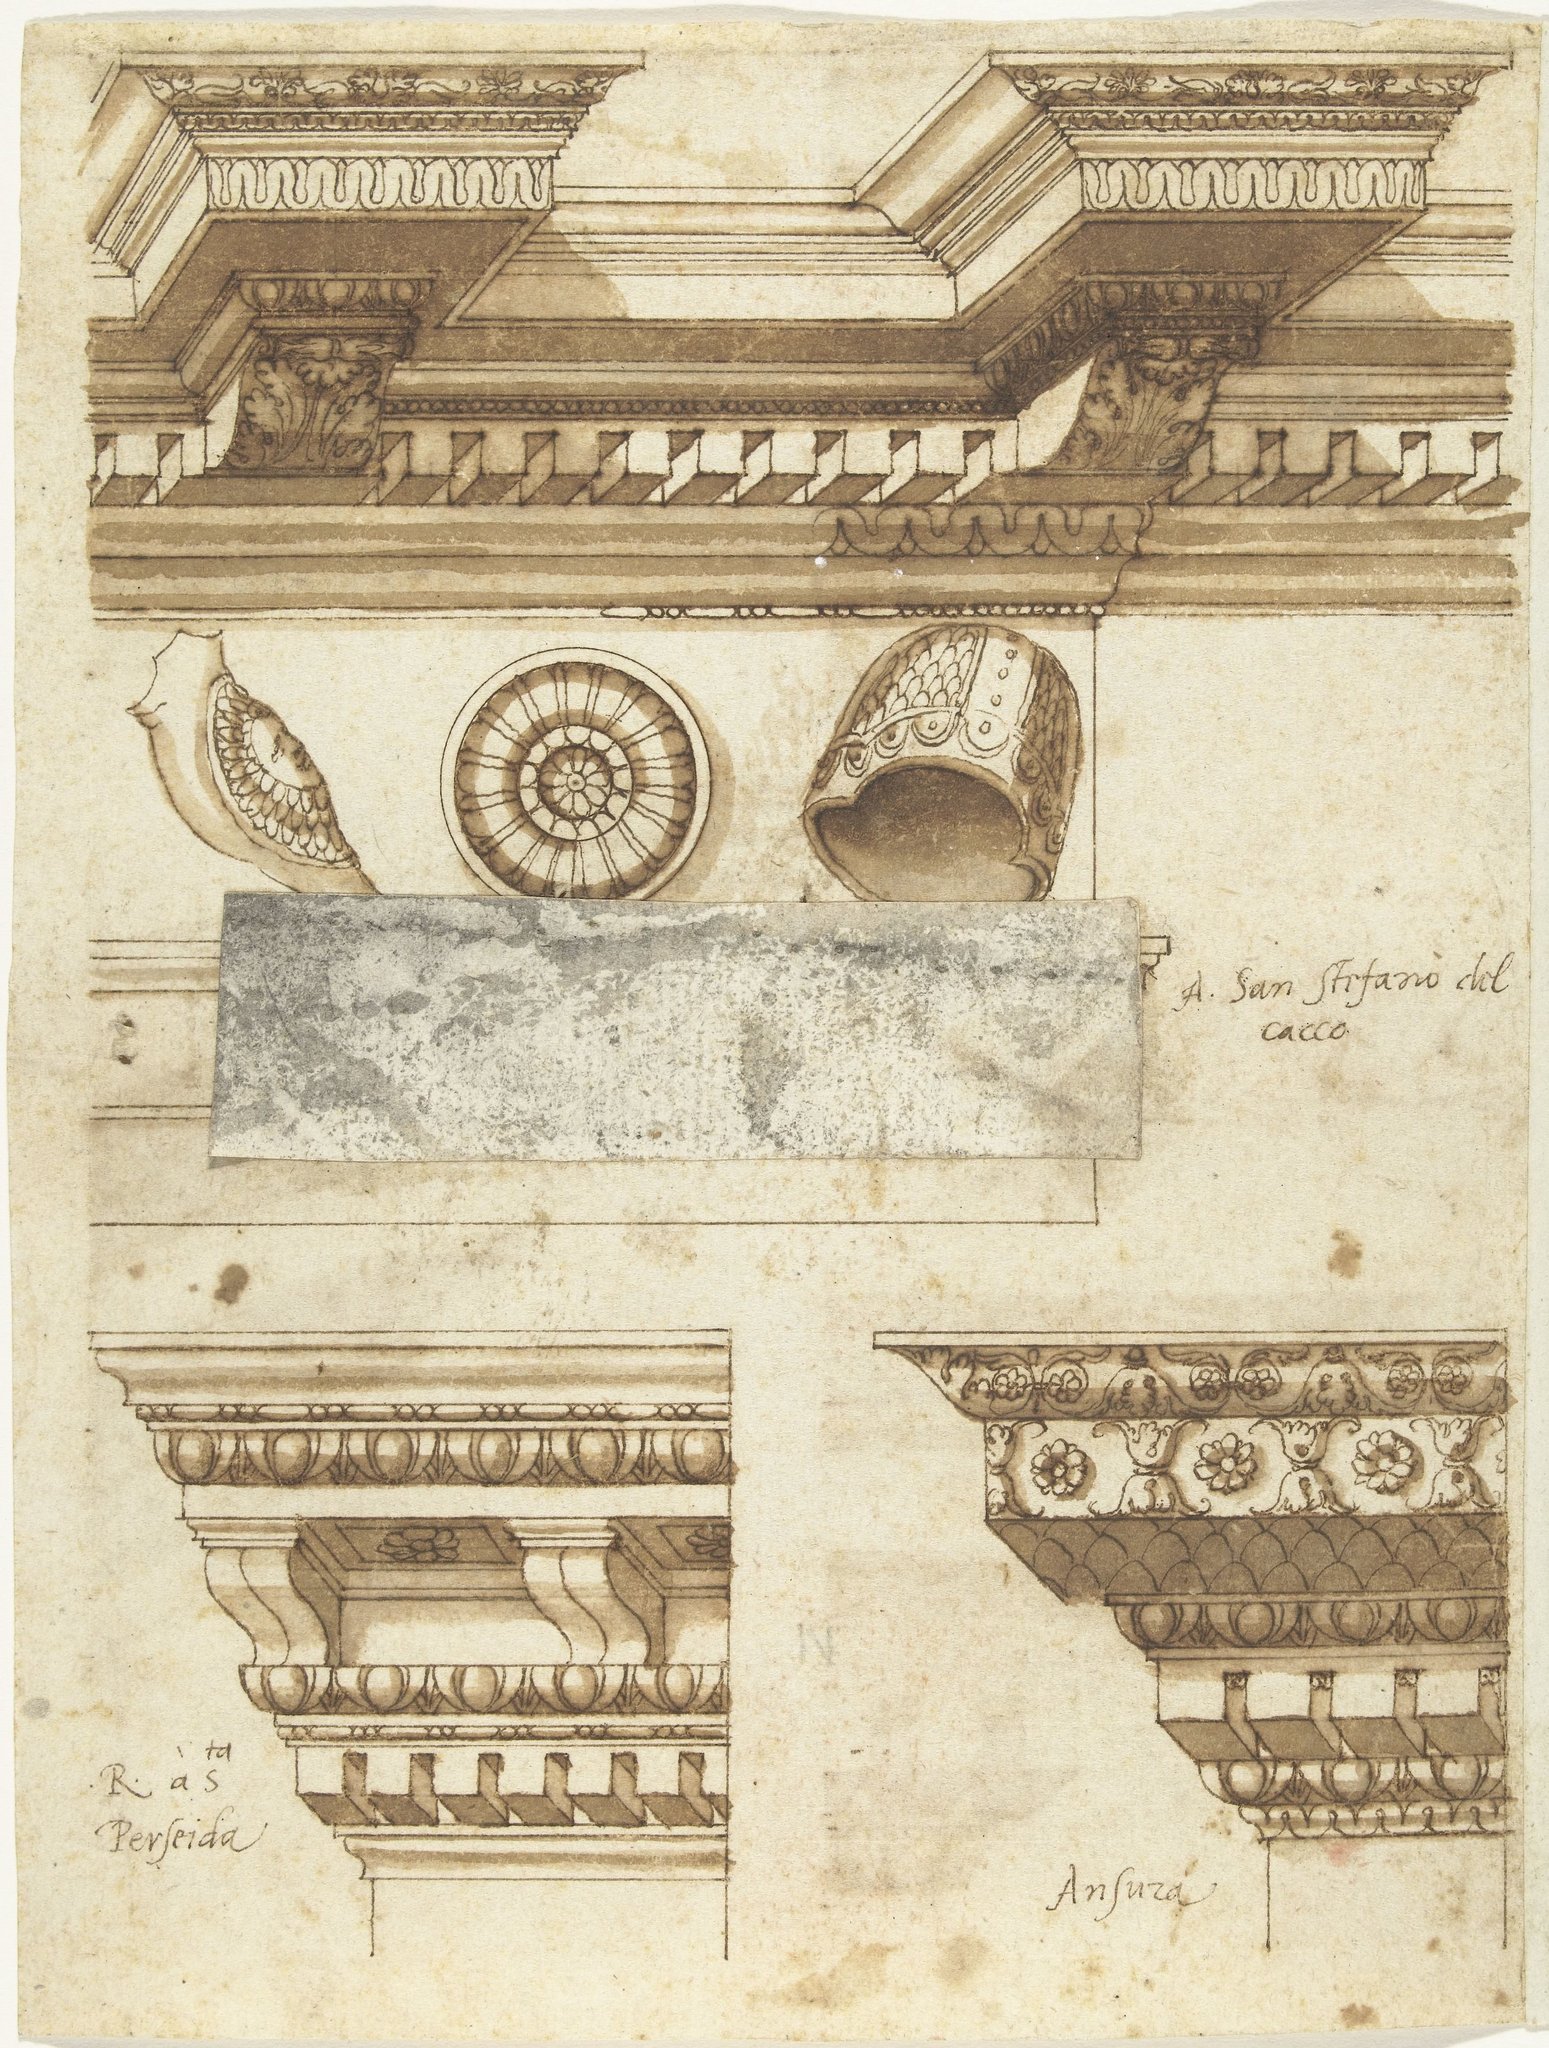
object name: drawing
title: Drie kroonlijsten, een helm en enkele ornamenten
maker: Anonymous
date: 1500-1599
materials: ink, paper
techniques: brush, pen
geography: italy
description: Blad met natekeningen van architectuuronderdelen.